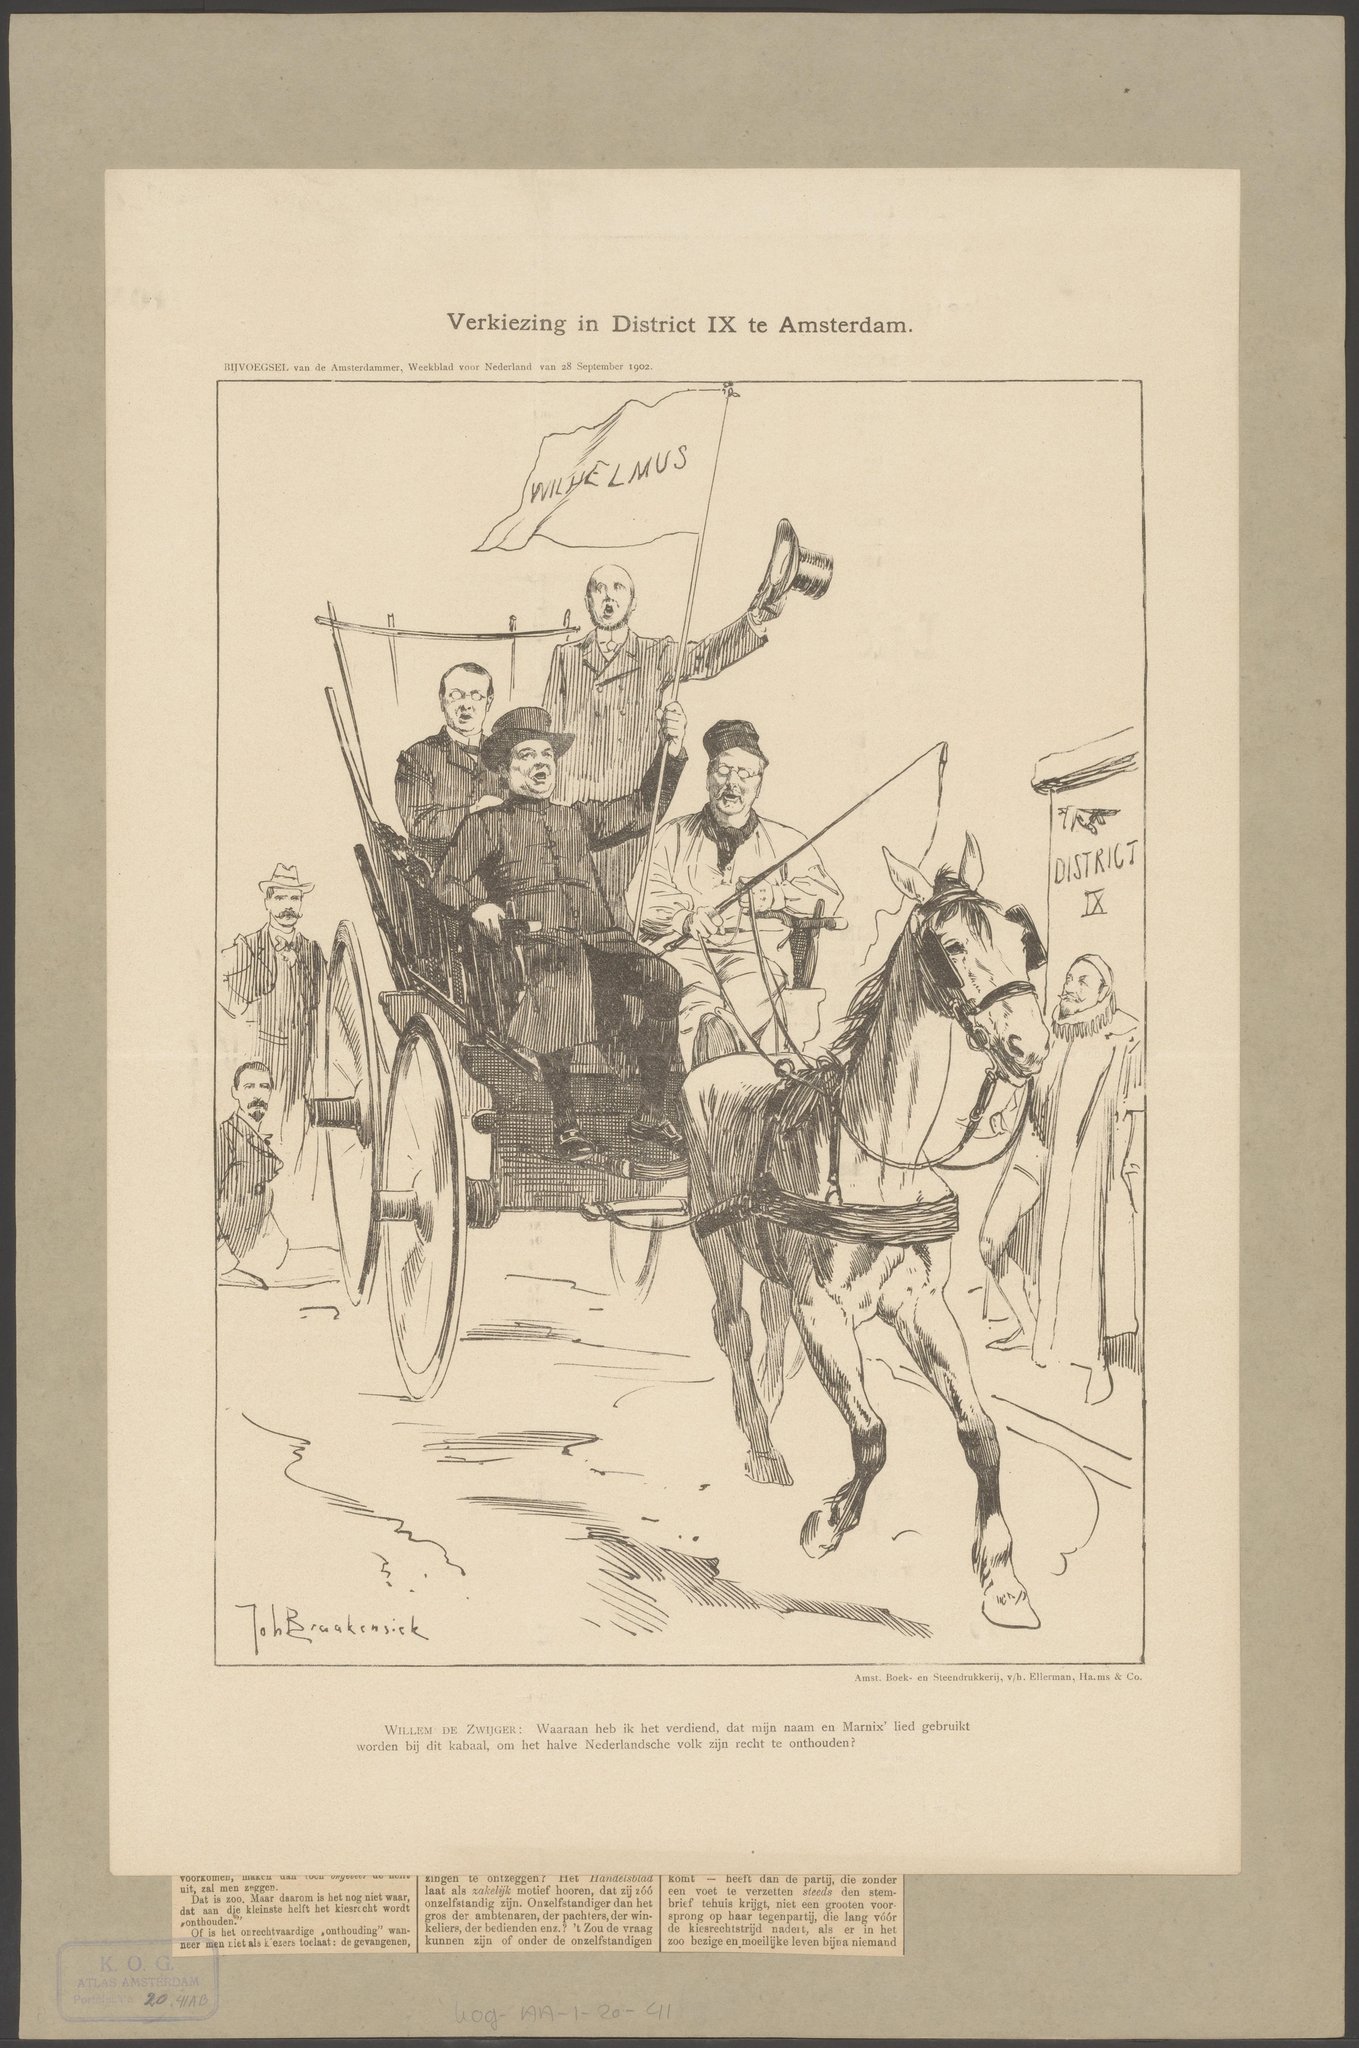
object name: cartoon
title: Verkiezing in District IX te Amsterdam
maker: johan braakensiek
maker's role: draughtsman, print maker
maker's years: 1858-1940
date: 1902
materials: paper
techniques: letterpress printing, lithograph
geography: netherlands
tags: politician, william i (prince of orange), four-wheeled vehicle drawn by one animal, voting, election, singer without accompaniment - cc - out of doors, politician, e.g. party leader, political caricatures and satires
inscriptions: collector's mark: Lugt 1641b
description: Willem van Oranje ziet verbijsterd toe hoe de inzittenden van een verkiezingskar triomfantelijk luidkeels het Wilhelmus zingen. Na de overwinning van christelijke en antirevolutionaire partijen op de socialisten van Troelstra. Onderwerpsrubriek binnen de Atlas Amsterdam: Verkiezingen Tweede Kamer. Het bijbehorende artikel werd ook op het opzetvel aangebracht.